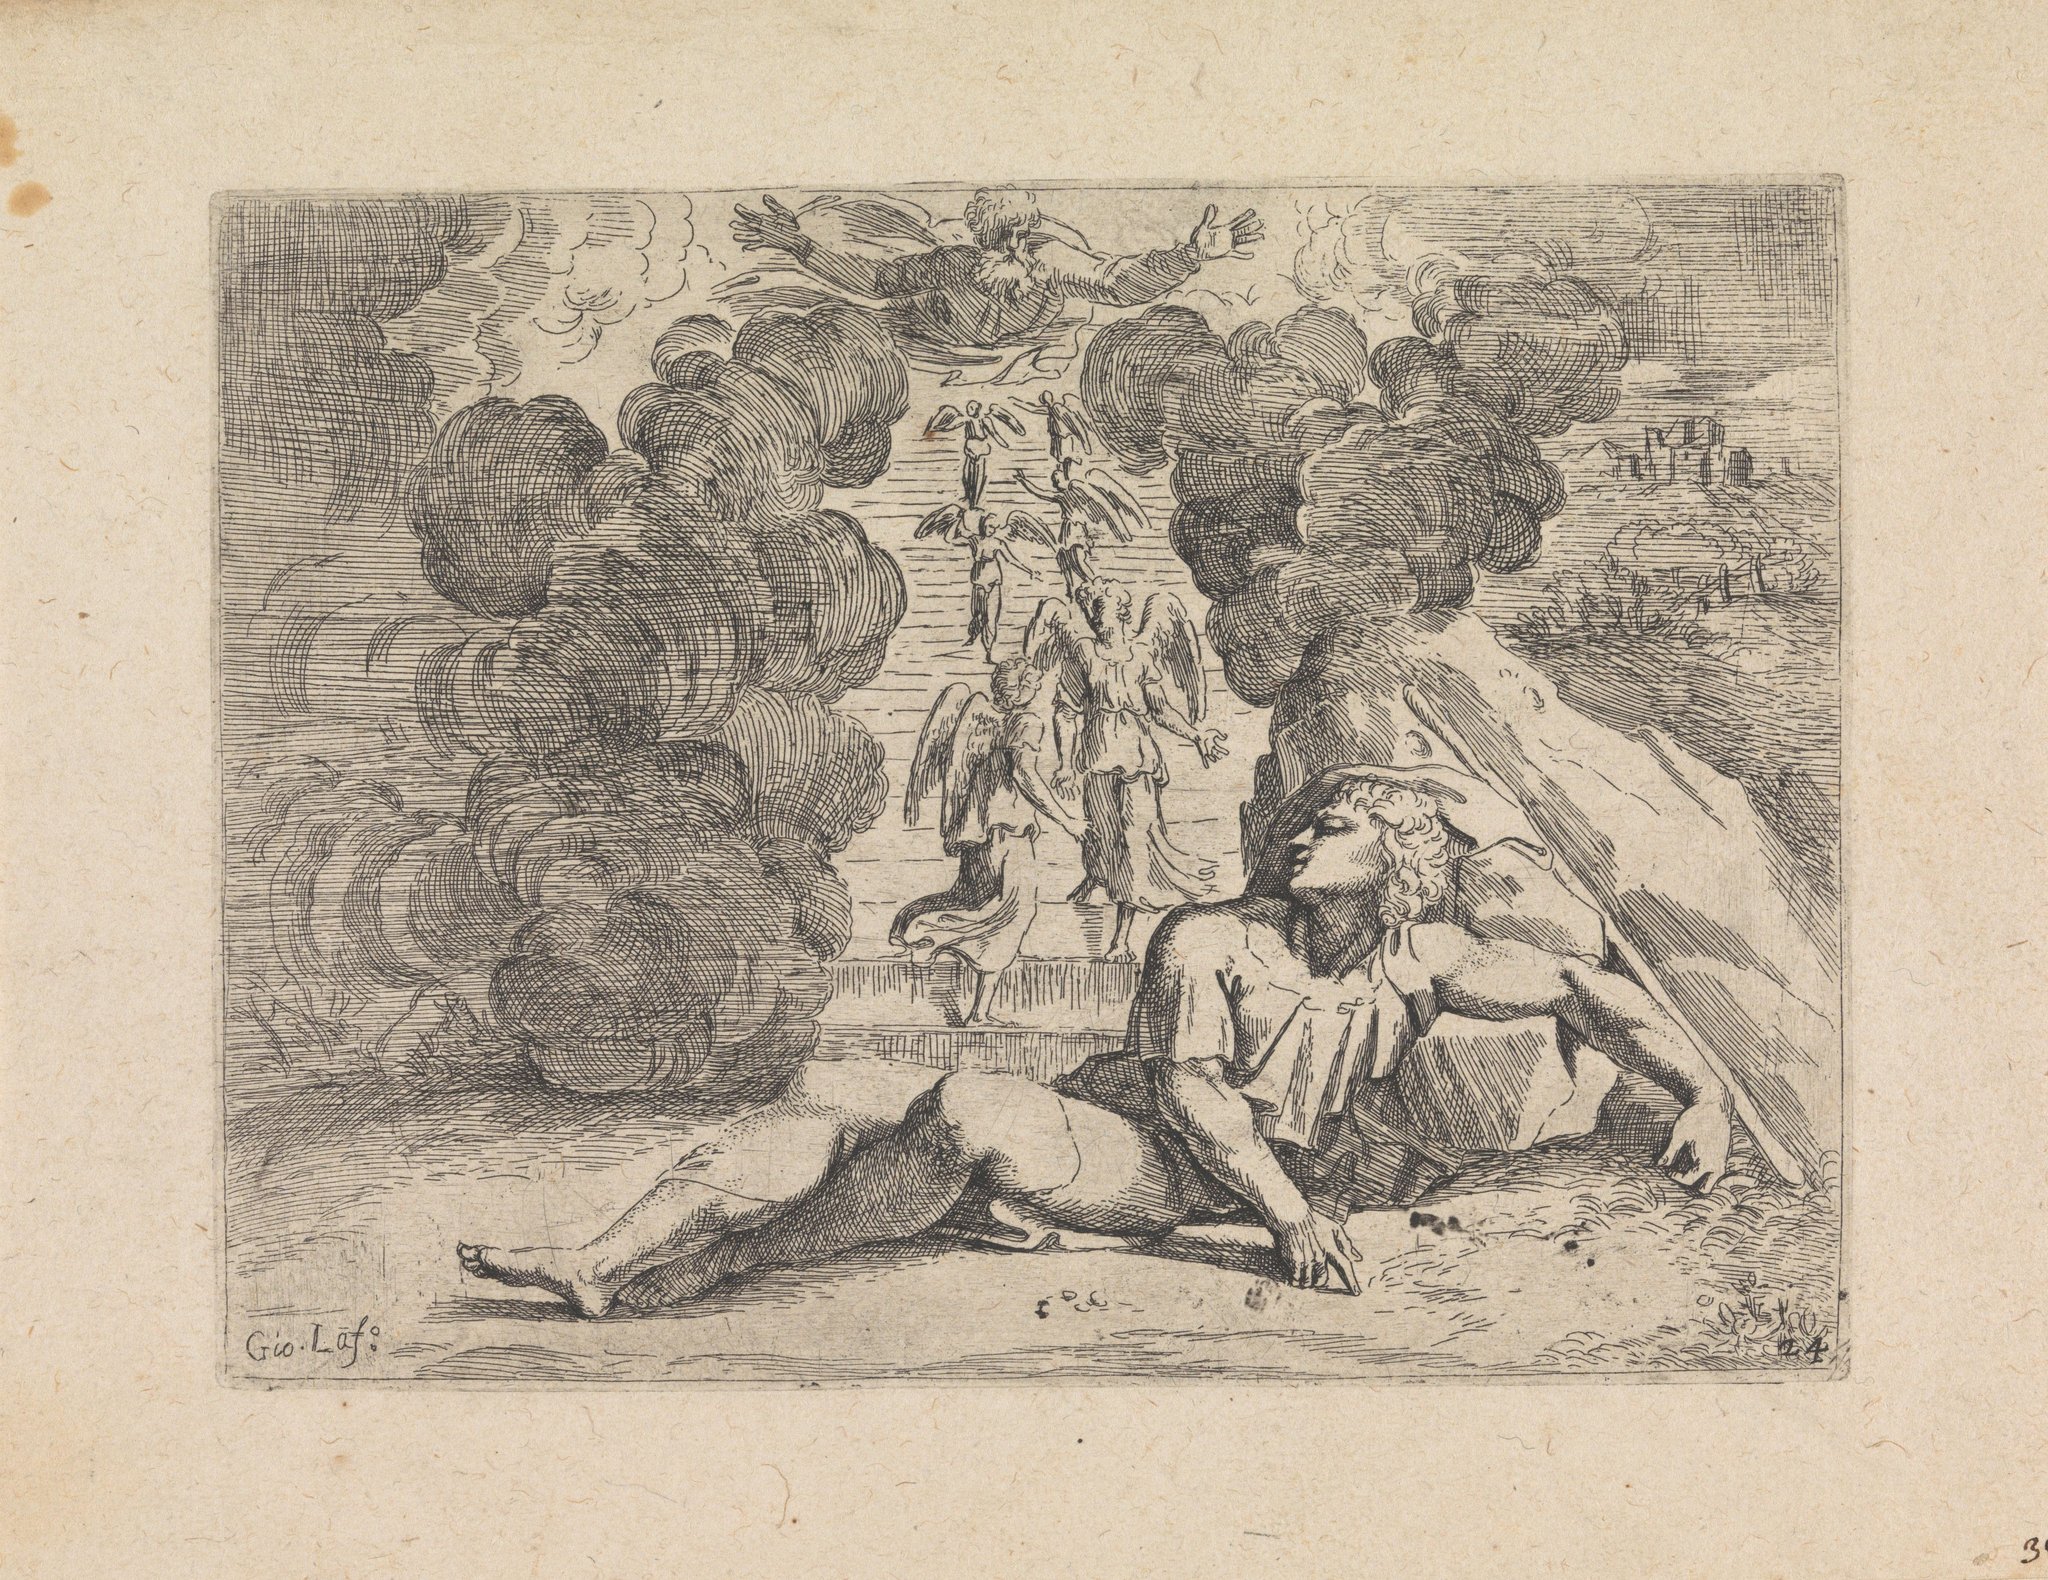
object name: print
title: Historia del Testamento Vecchio / Dipinta in Roma nel Vaticano da Raffaelle di Urbin (...)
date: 1607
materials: paper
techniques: etching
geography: italy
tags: the dream of jacob: while sleeping on the ground with a stone for pillow jacob sees a ladder reaching from earth to heaven with angels going up and down; usually with god at the top of the ladder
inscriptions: collector's mark: ‘Hinloopen’, collector's mark: Lugt 11, number: ‘31’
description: Jakob ligt te slapen, met zijn hoofd op een steen. Hij droomt over een ladder die tot aan de hemel reikt en waarlangs engelen afdalen. Bij de top van de ladder zweeft God de Vader.